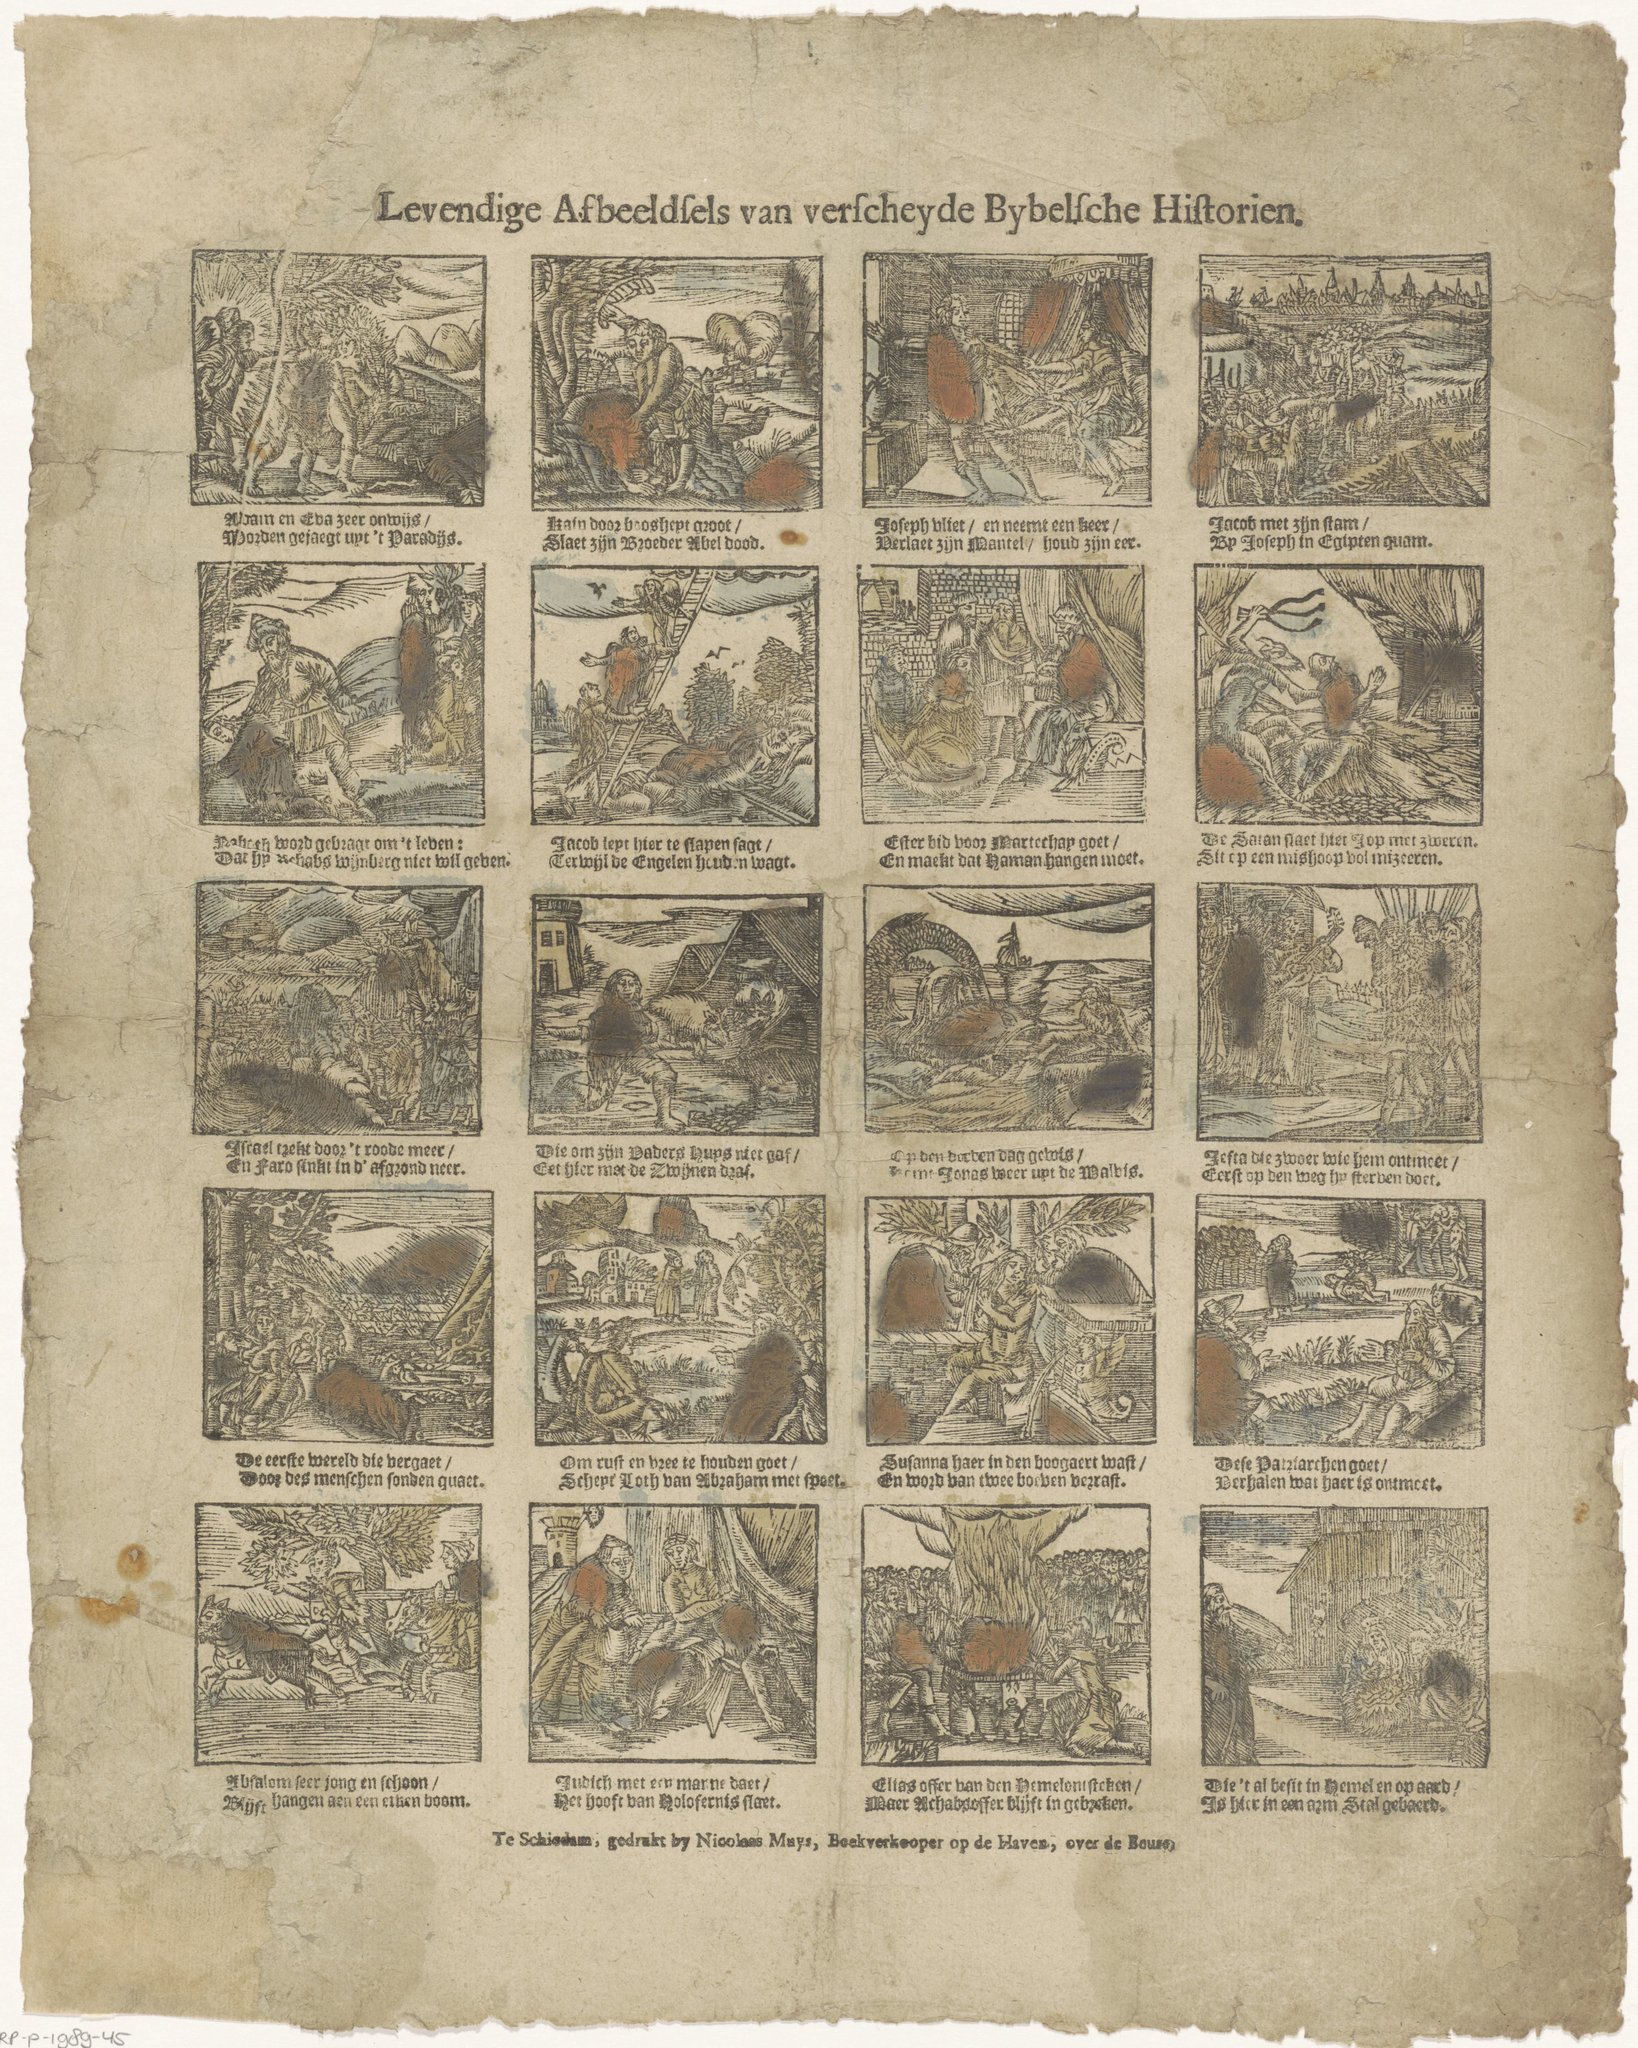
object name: print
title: Levendige afbeeldsels van verscheyde Bybelsche historien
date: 1704-1757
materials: paper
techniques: colour, letterpress printing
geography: netherlands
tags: abel's death, the elders spying upon susanna, story of jacob, old testament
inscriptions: collector's mark: Lugt 2228, collector's mark: Lugt 2760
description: Blad met 20 voorstellingen uit het Oude Testament, waaronder Kaïn die Abel vermoordt, Jakobs ladder en Susanna die wordt bespied door twee oudere mannen. Onder elke afbeedling een tweeregelig vers.